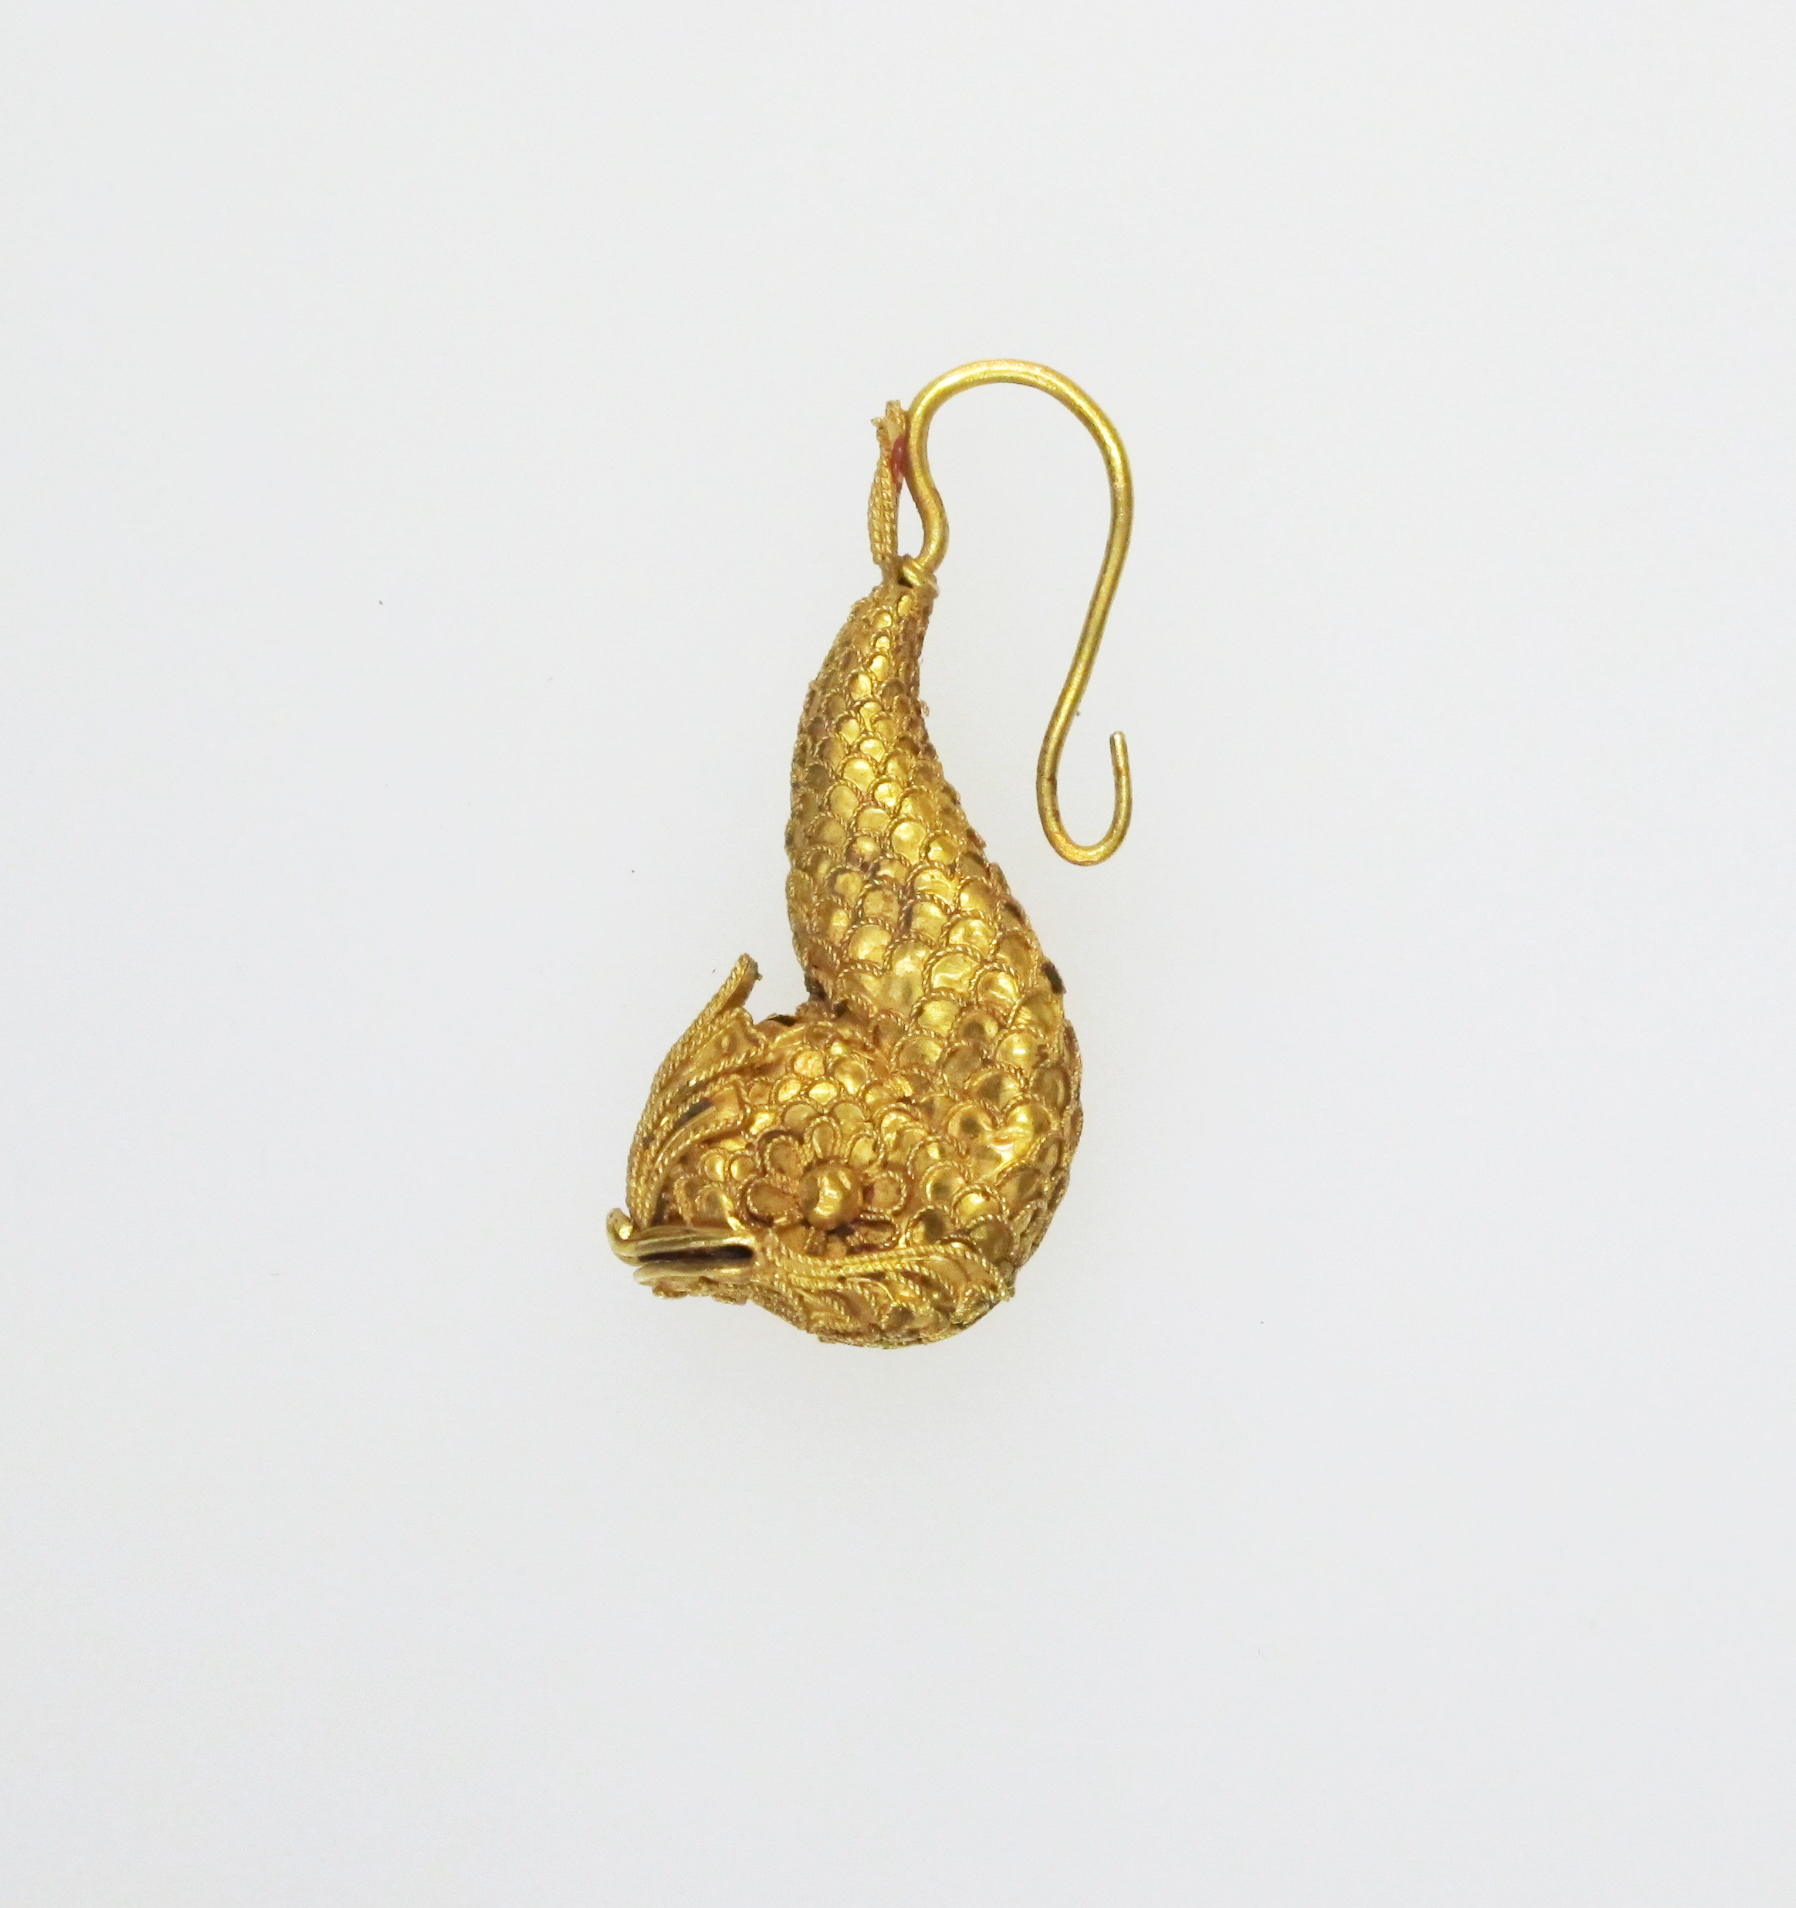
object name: earring in the form of a dolphin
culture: etruscan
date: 500-401 BCE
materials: gold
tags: dolphins